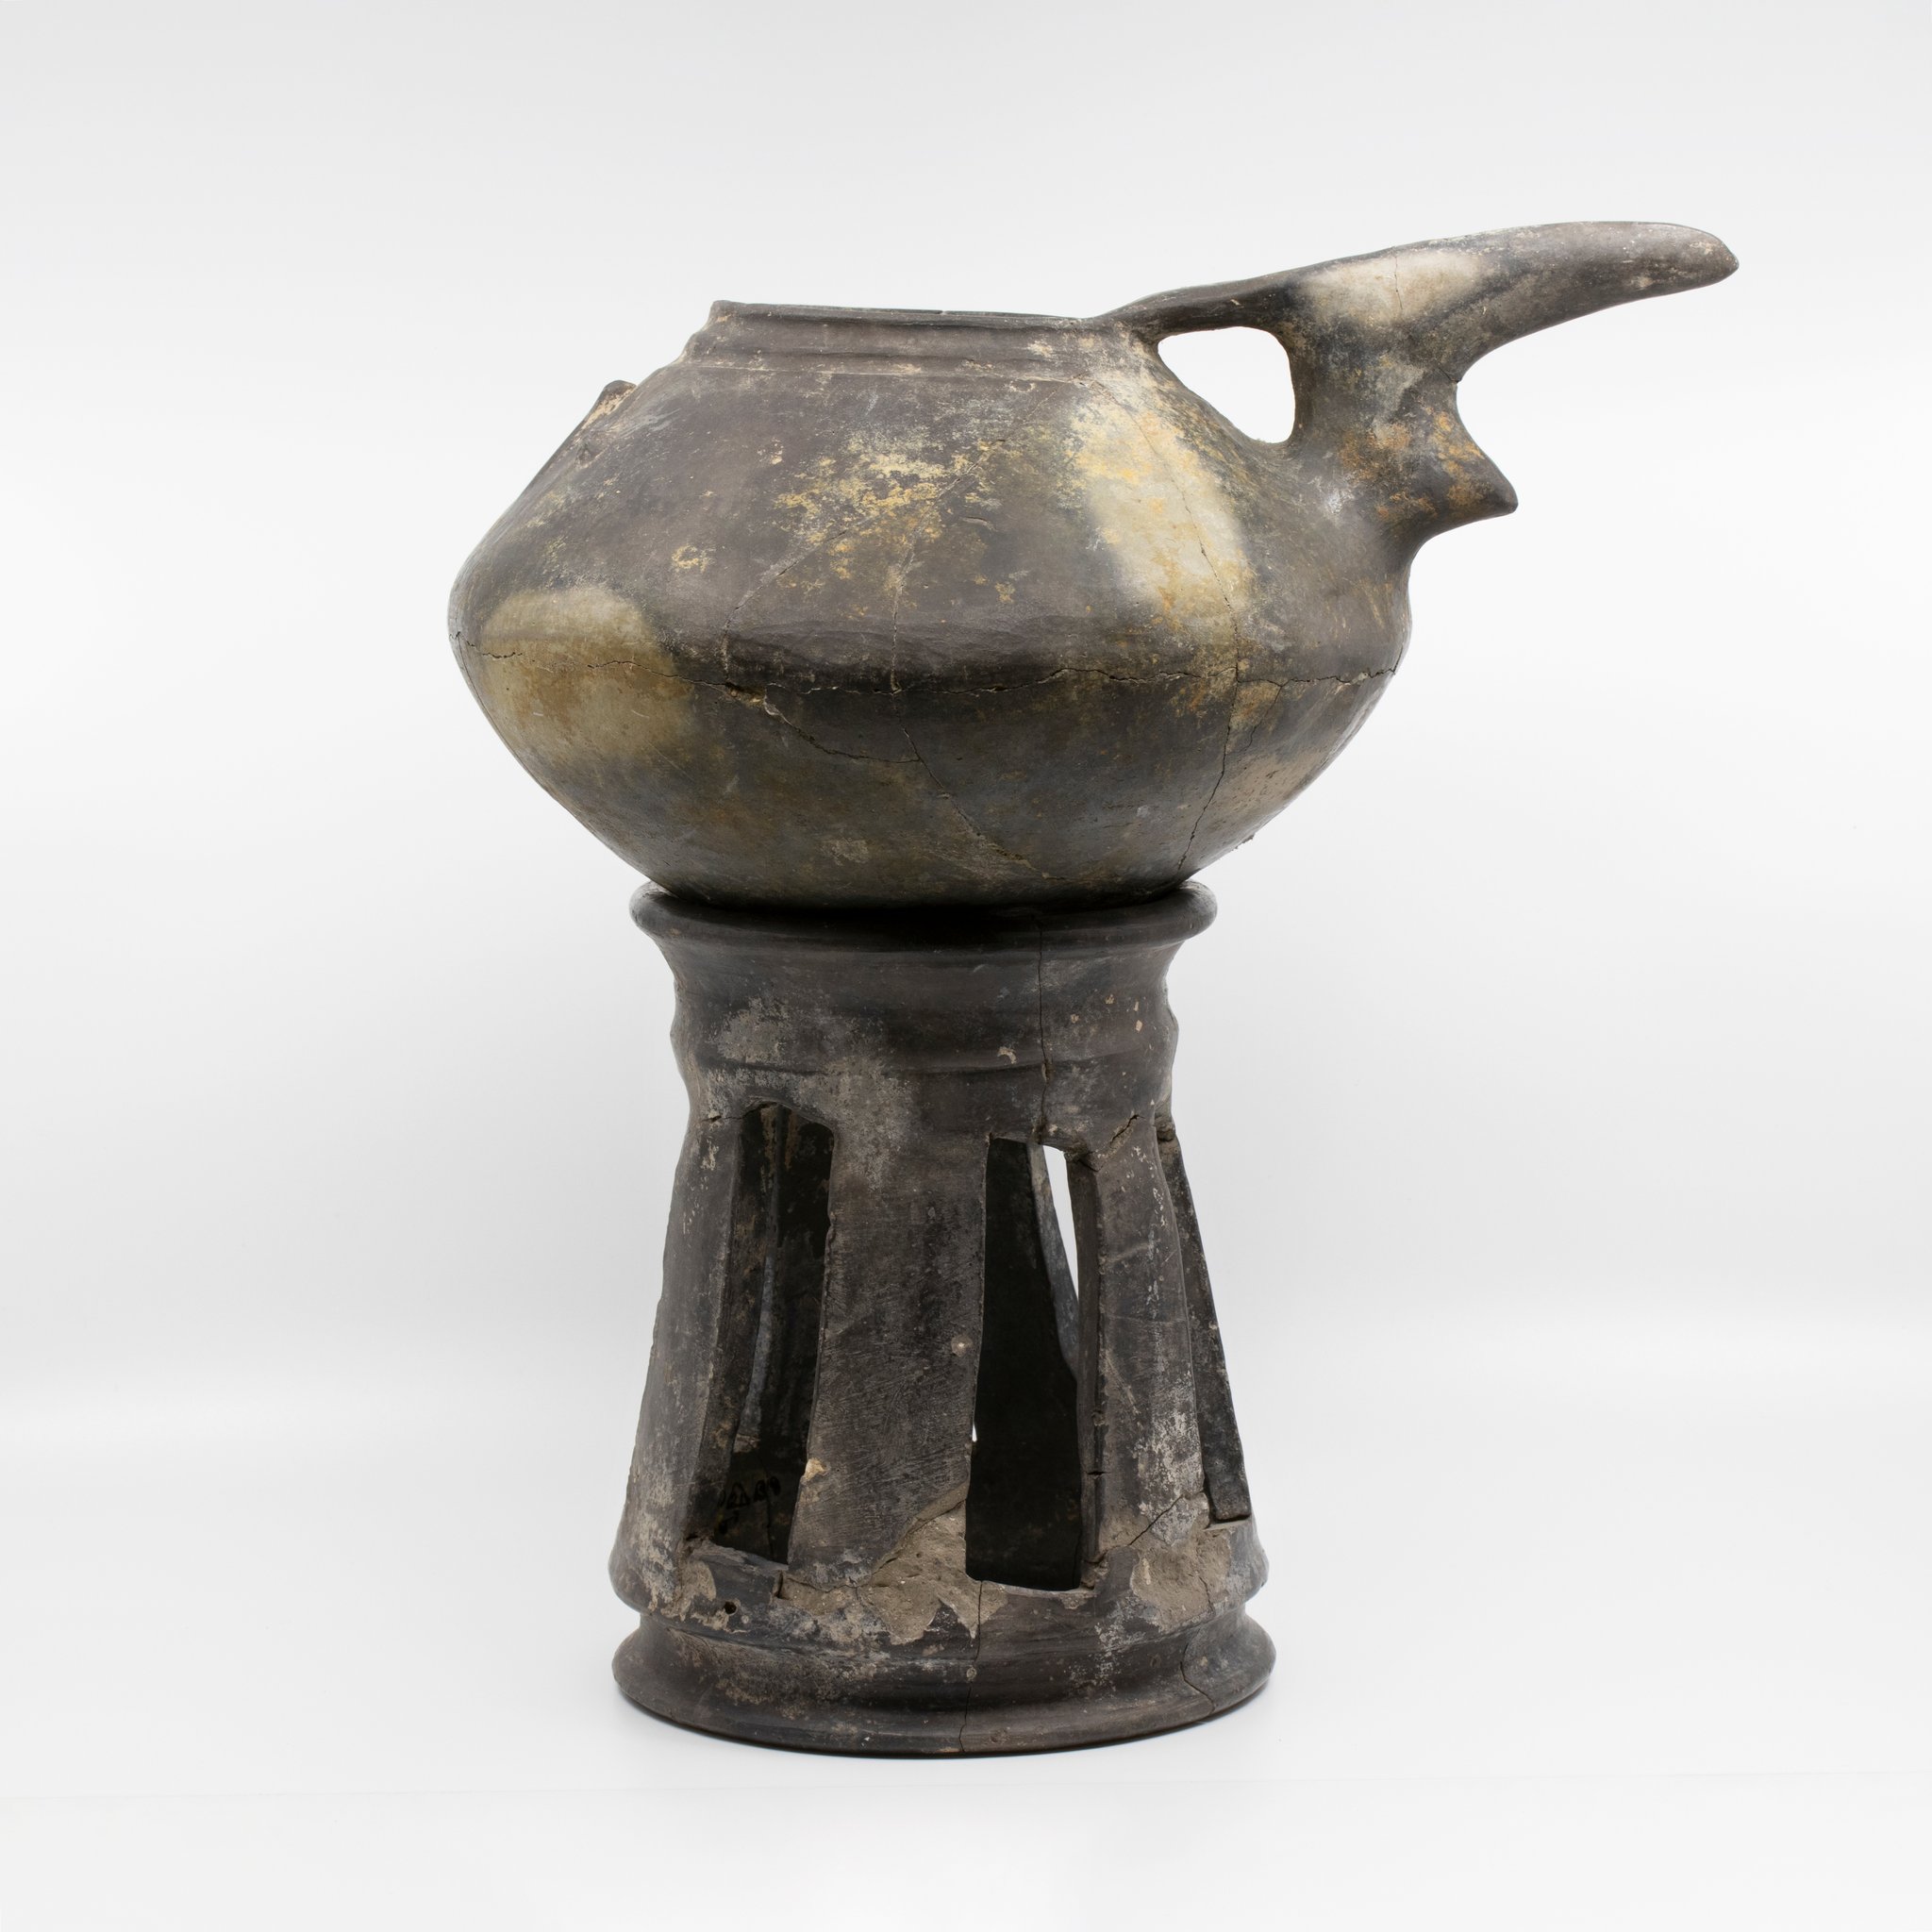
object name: jar and stand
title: Spouted jar and stand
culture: iranian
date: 1050-800 BCE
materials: ceramic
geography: iran